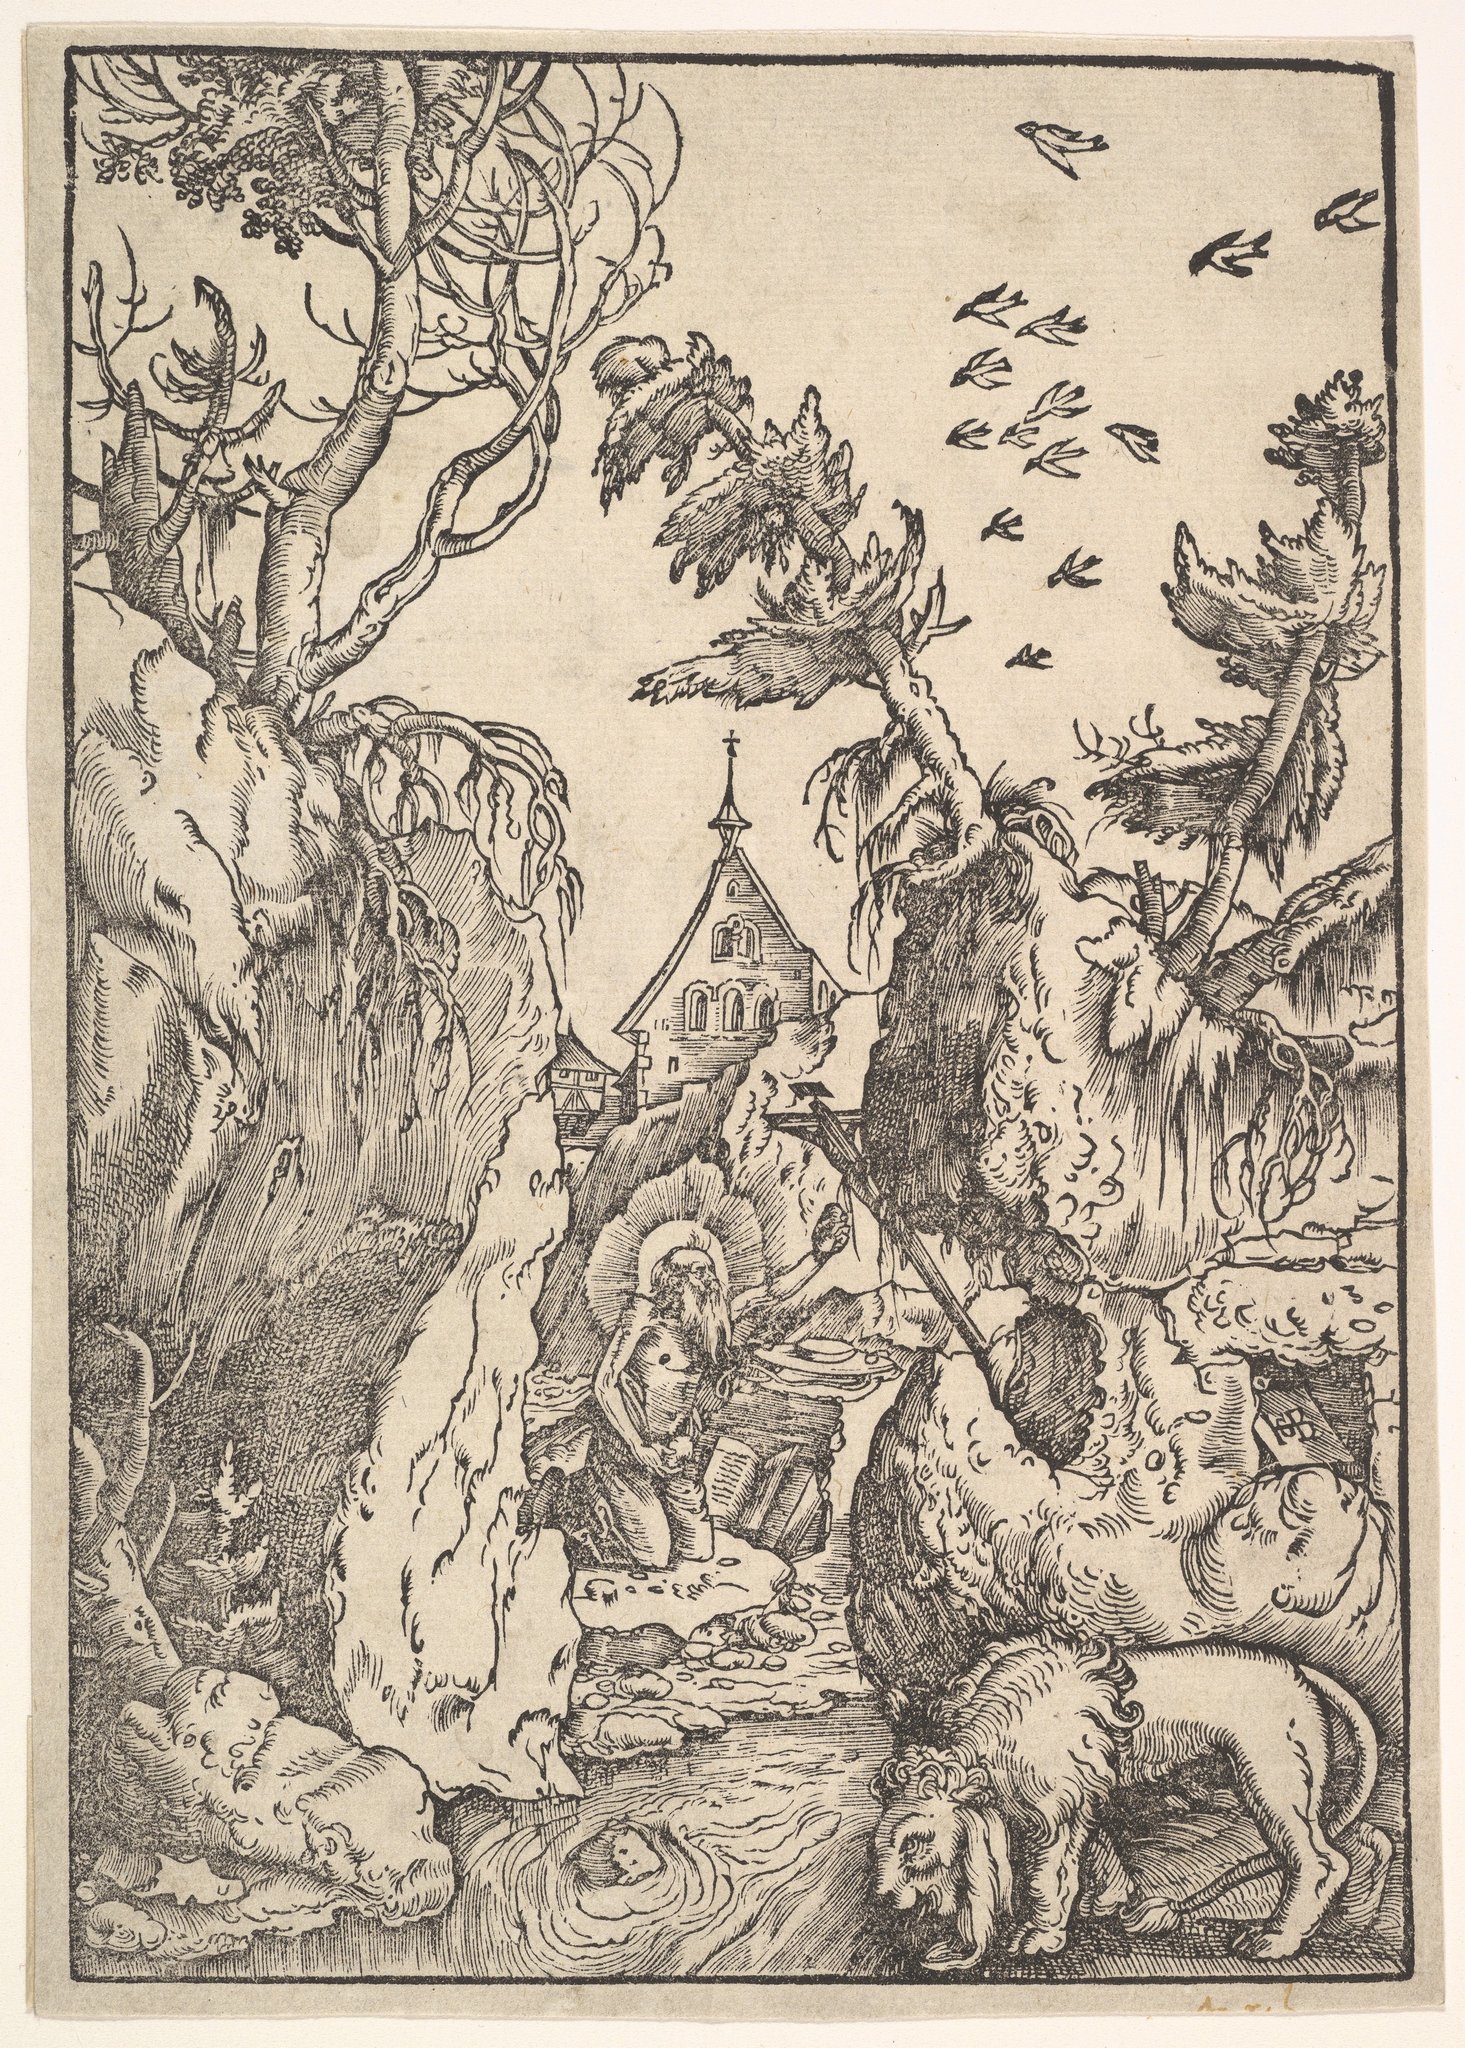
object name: print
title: St. Jerome in the Desert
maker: hans baldung (called hans baldung grien)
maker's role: artist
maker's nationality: german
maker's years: 1484-1545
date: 1511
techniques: woodcut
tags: saint jerome,cross